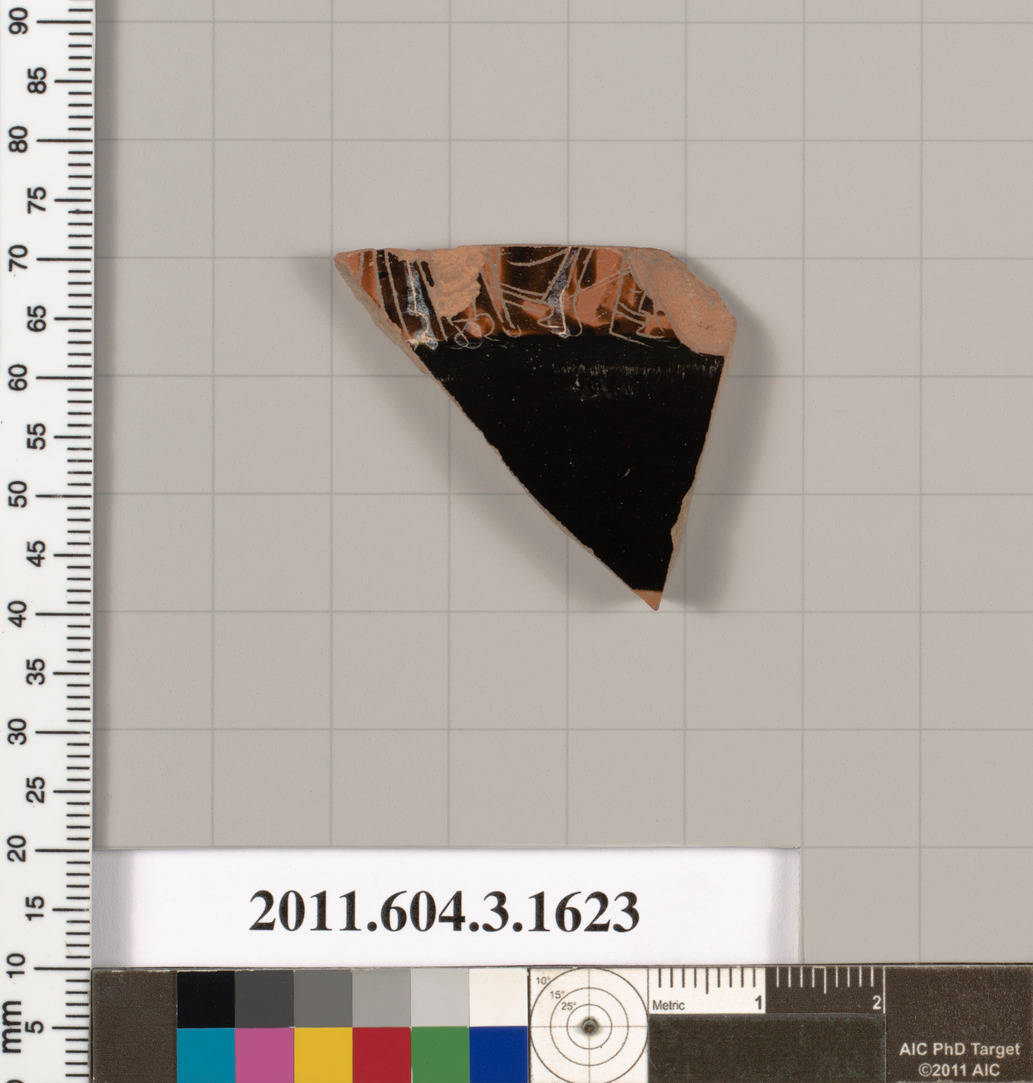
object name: kylix fragment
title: Terracotta fragment of a kylix: Band cup (drinking cup)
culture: greek, attic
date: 550-526 BCE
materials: terracotta